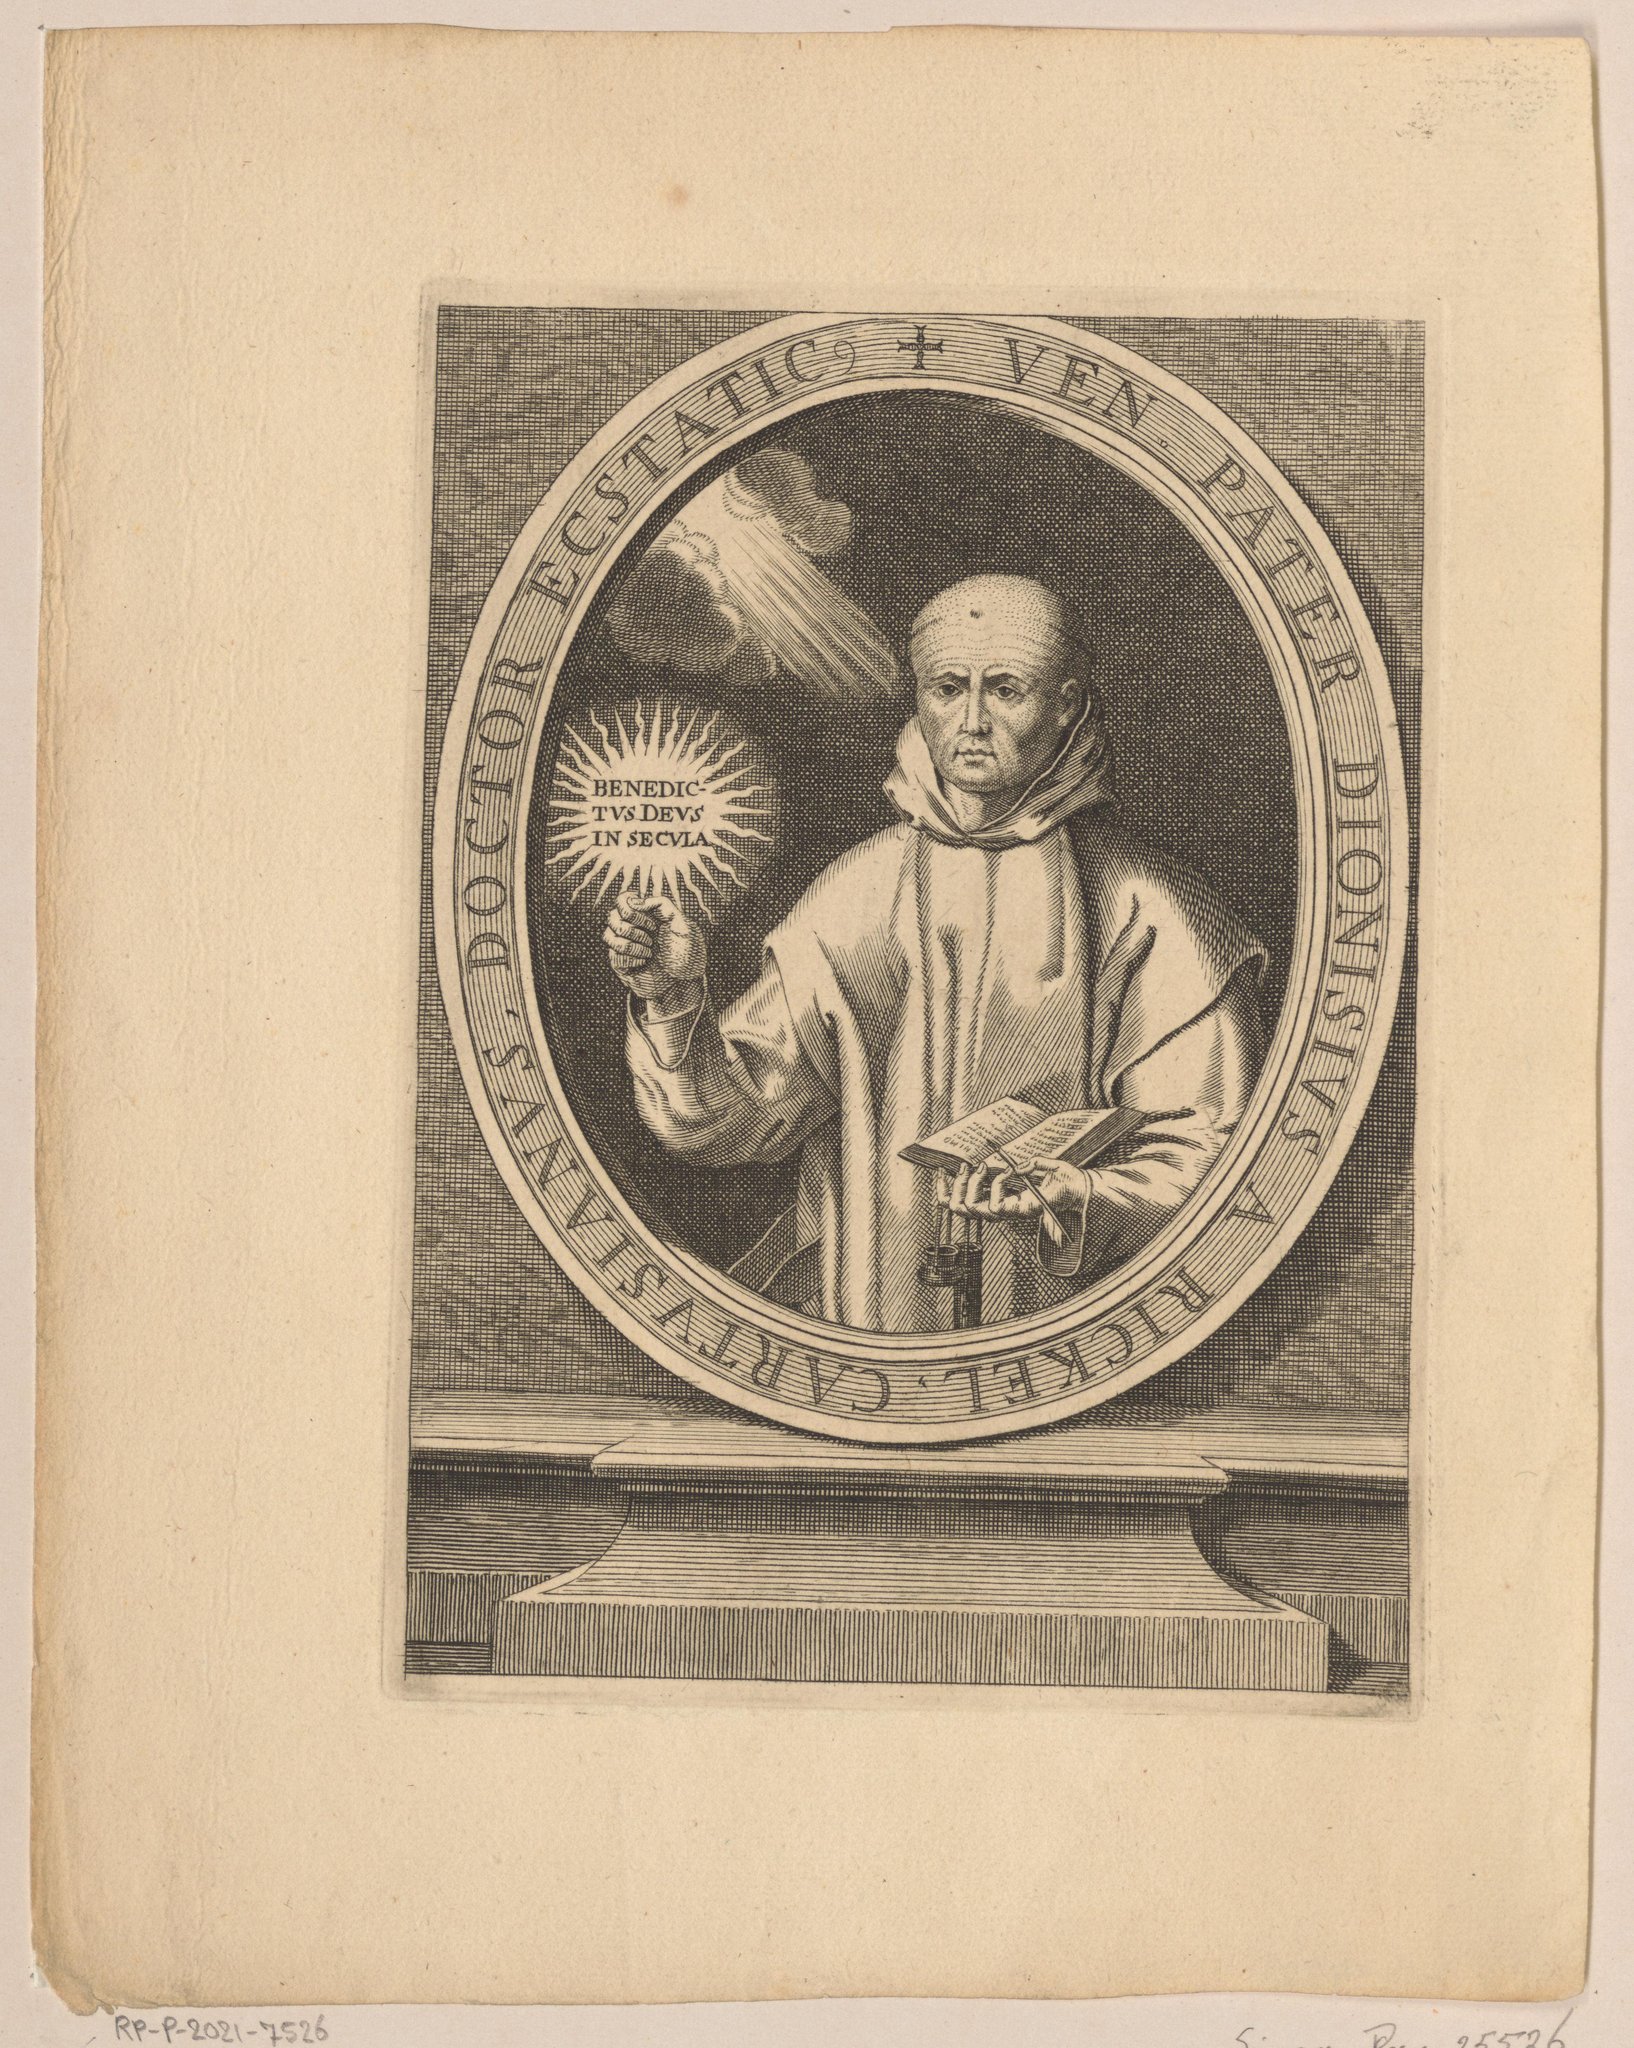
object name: print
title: Portret van Dionysius van Leuwis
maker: Anonymous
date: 1650-1749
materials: paper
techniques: engraving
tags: historical persons, book